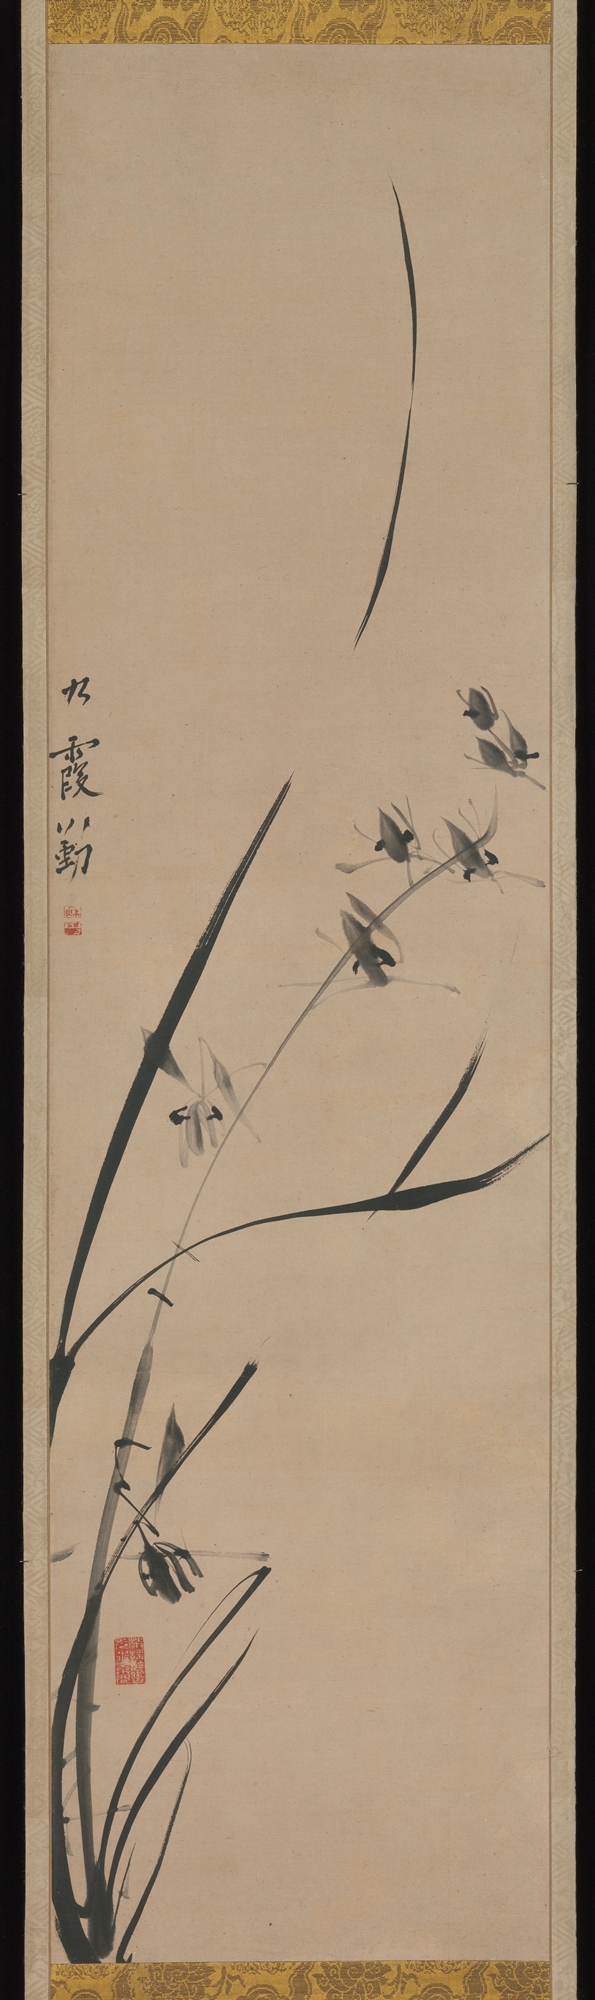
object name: hanging scroll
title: Orchids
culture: japanese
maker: ike no taiga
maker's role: artist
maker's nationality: japanese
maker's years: 1723-1776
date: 1749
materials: ink, paper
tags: orchids